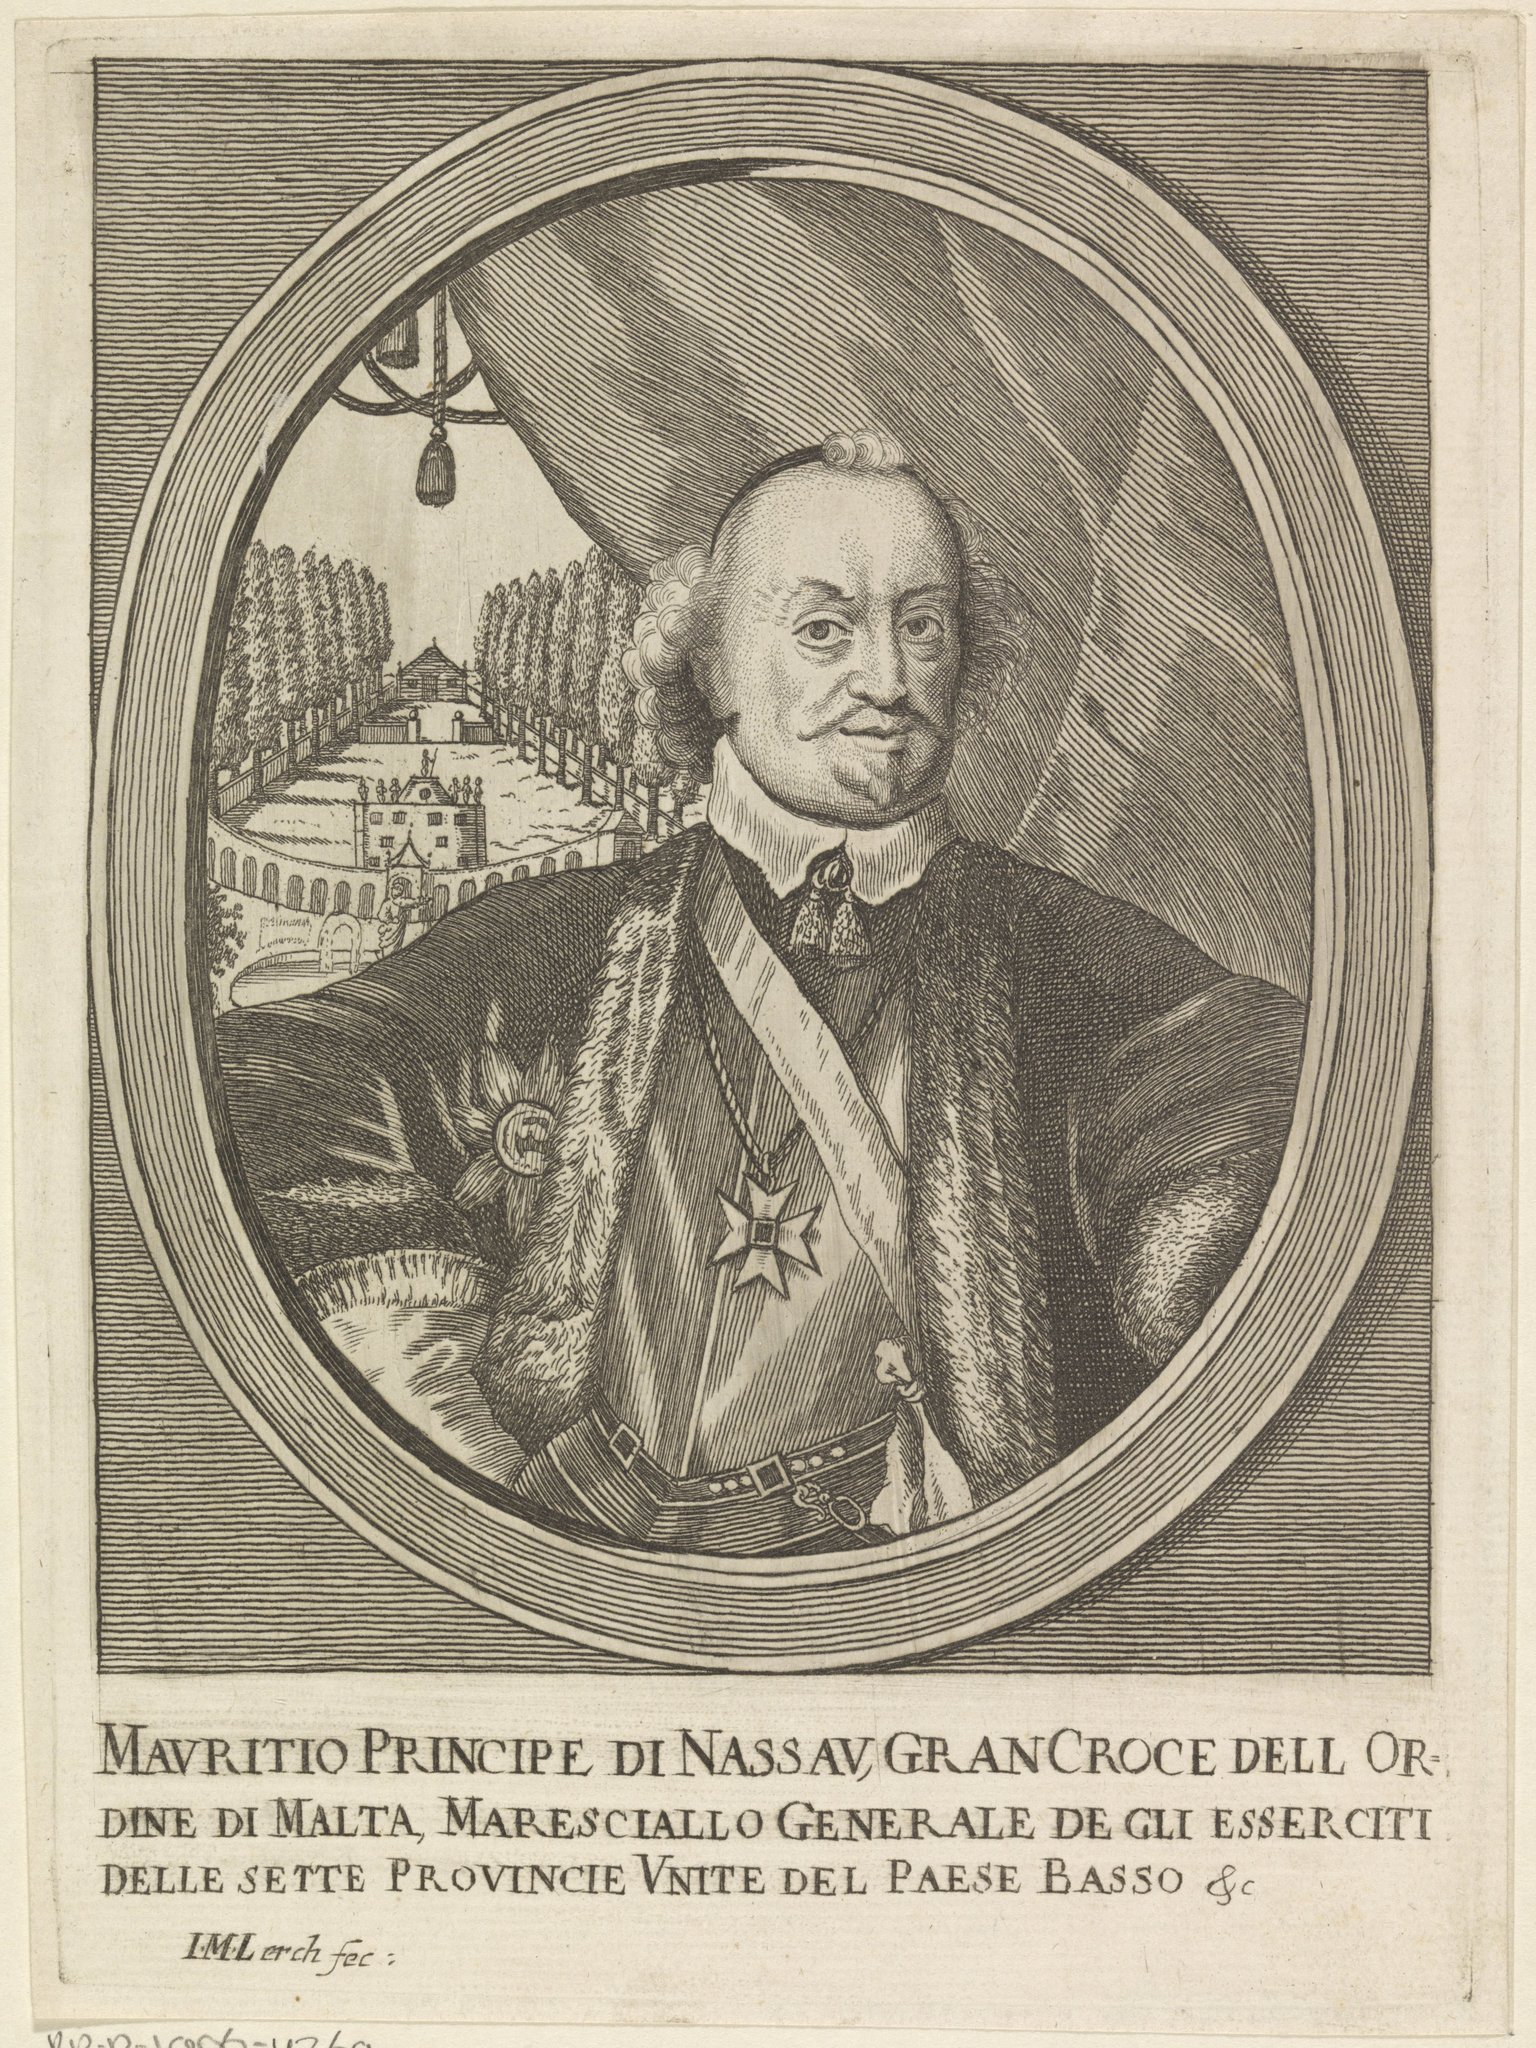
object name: print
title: Portret van Johan Maurits, graaf van Nassau-Siegen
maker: johann martin lerch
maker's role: print maker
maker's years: 1643-1693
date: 1659-1693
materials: paper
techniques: engraving, etching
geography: vienna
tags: earl, johan maurits graaf van nassau-siegen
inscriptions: collector's mark: Lugt 2228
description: De hier vermelde titel verwijst naar de hoogst verkregen titel van de geportretteerde, niet per se naar de titel die de geportretteerde op deze voorstelling draagt.